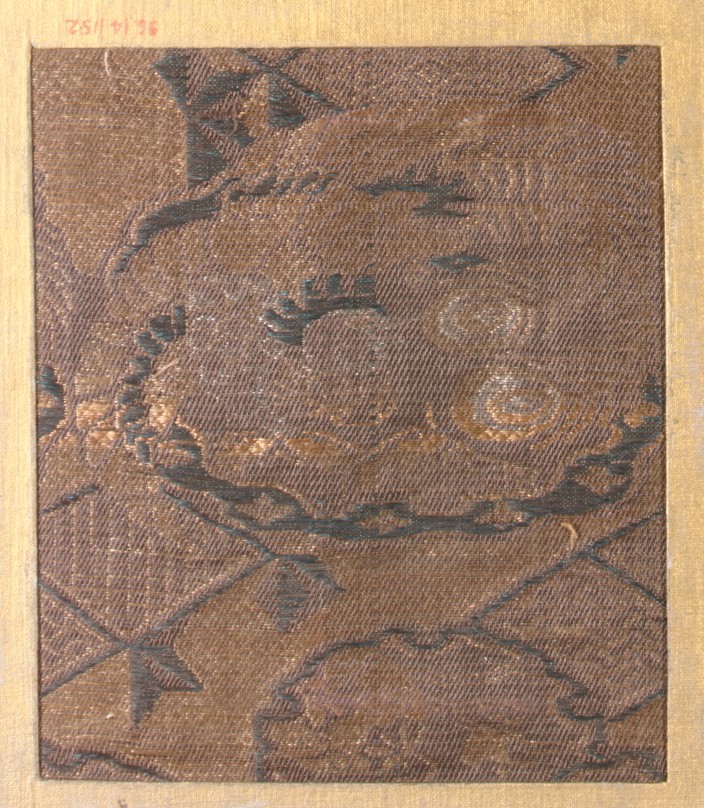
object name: piece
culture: japanese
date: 1701-1900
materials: silk